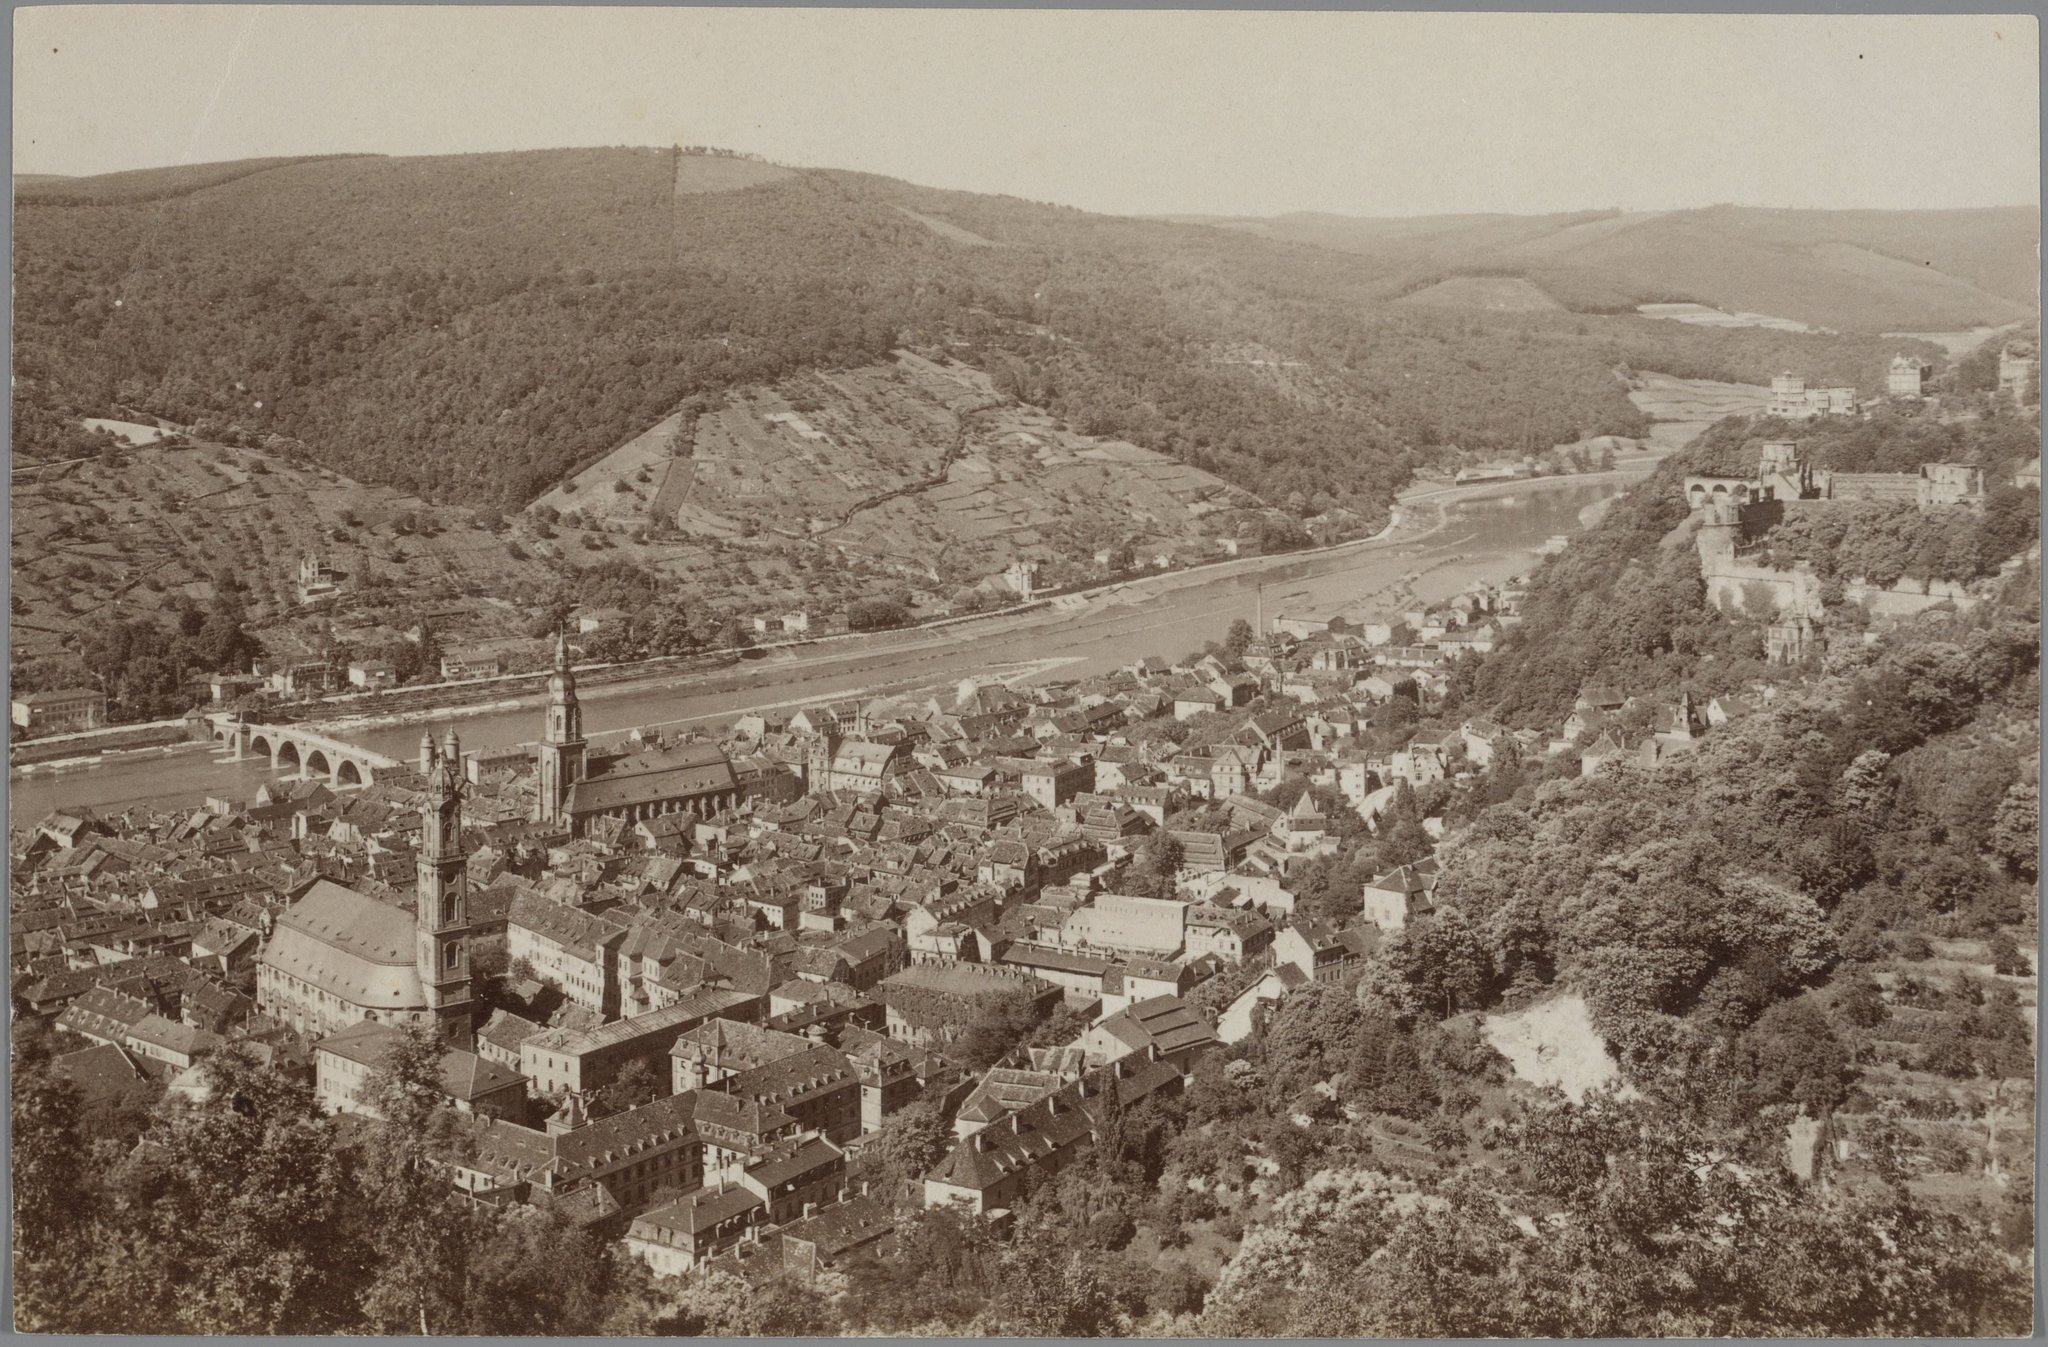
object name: photograph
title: Gezicht op Heidelberg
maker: carl lange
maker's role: print maker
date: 1897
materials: paper, photographic support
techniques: albumen print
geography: heidelberg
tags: bridge in city across river, canal, etc., prospect of city, town panorama, silhouette of city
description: De Onderdeel van Fotoalbum van Robert Daniel Crommelin (1841-1907).